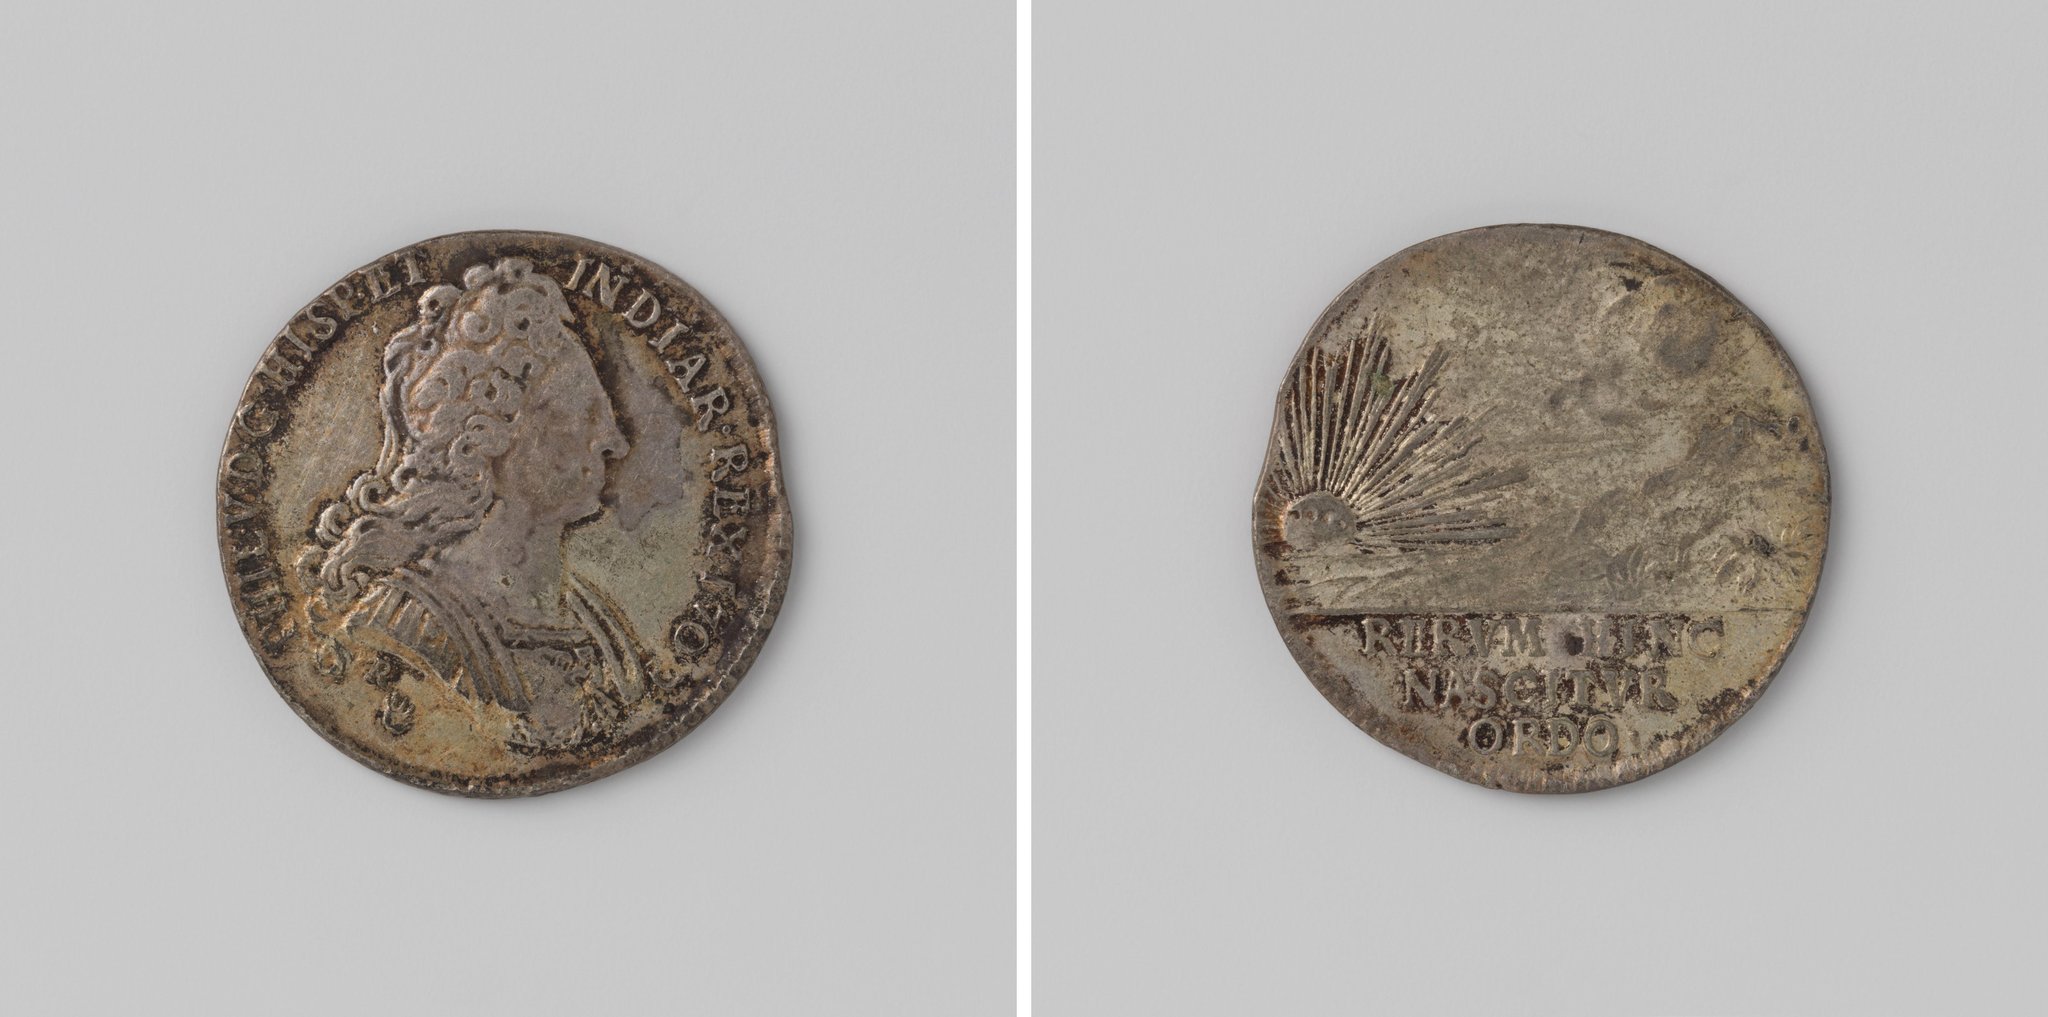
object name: history medal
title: Inhuldiging van Filips V te Brussel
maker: philippe roëttiers (ii)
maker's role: medailleur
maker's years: 1640-1718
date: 1702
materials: silver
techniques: striking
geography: antwerp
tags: filips v (koning van spanje), brussels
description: Zilveren penning. Voorzijde: borststuk man binnen omschrift. Keerzijde: opkomende zon beschijnt berglandschap; afsnede: opschrift